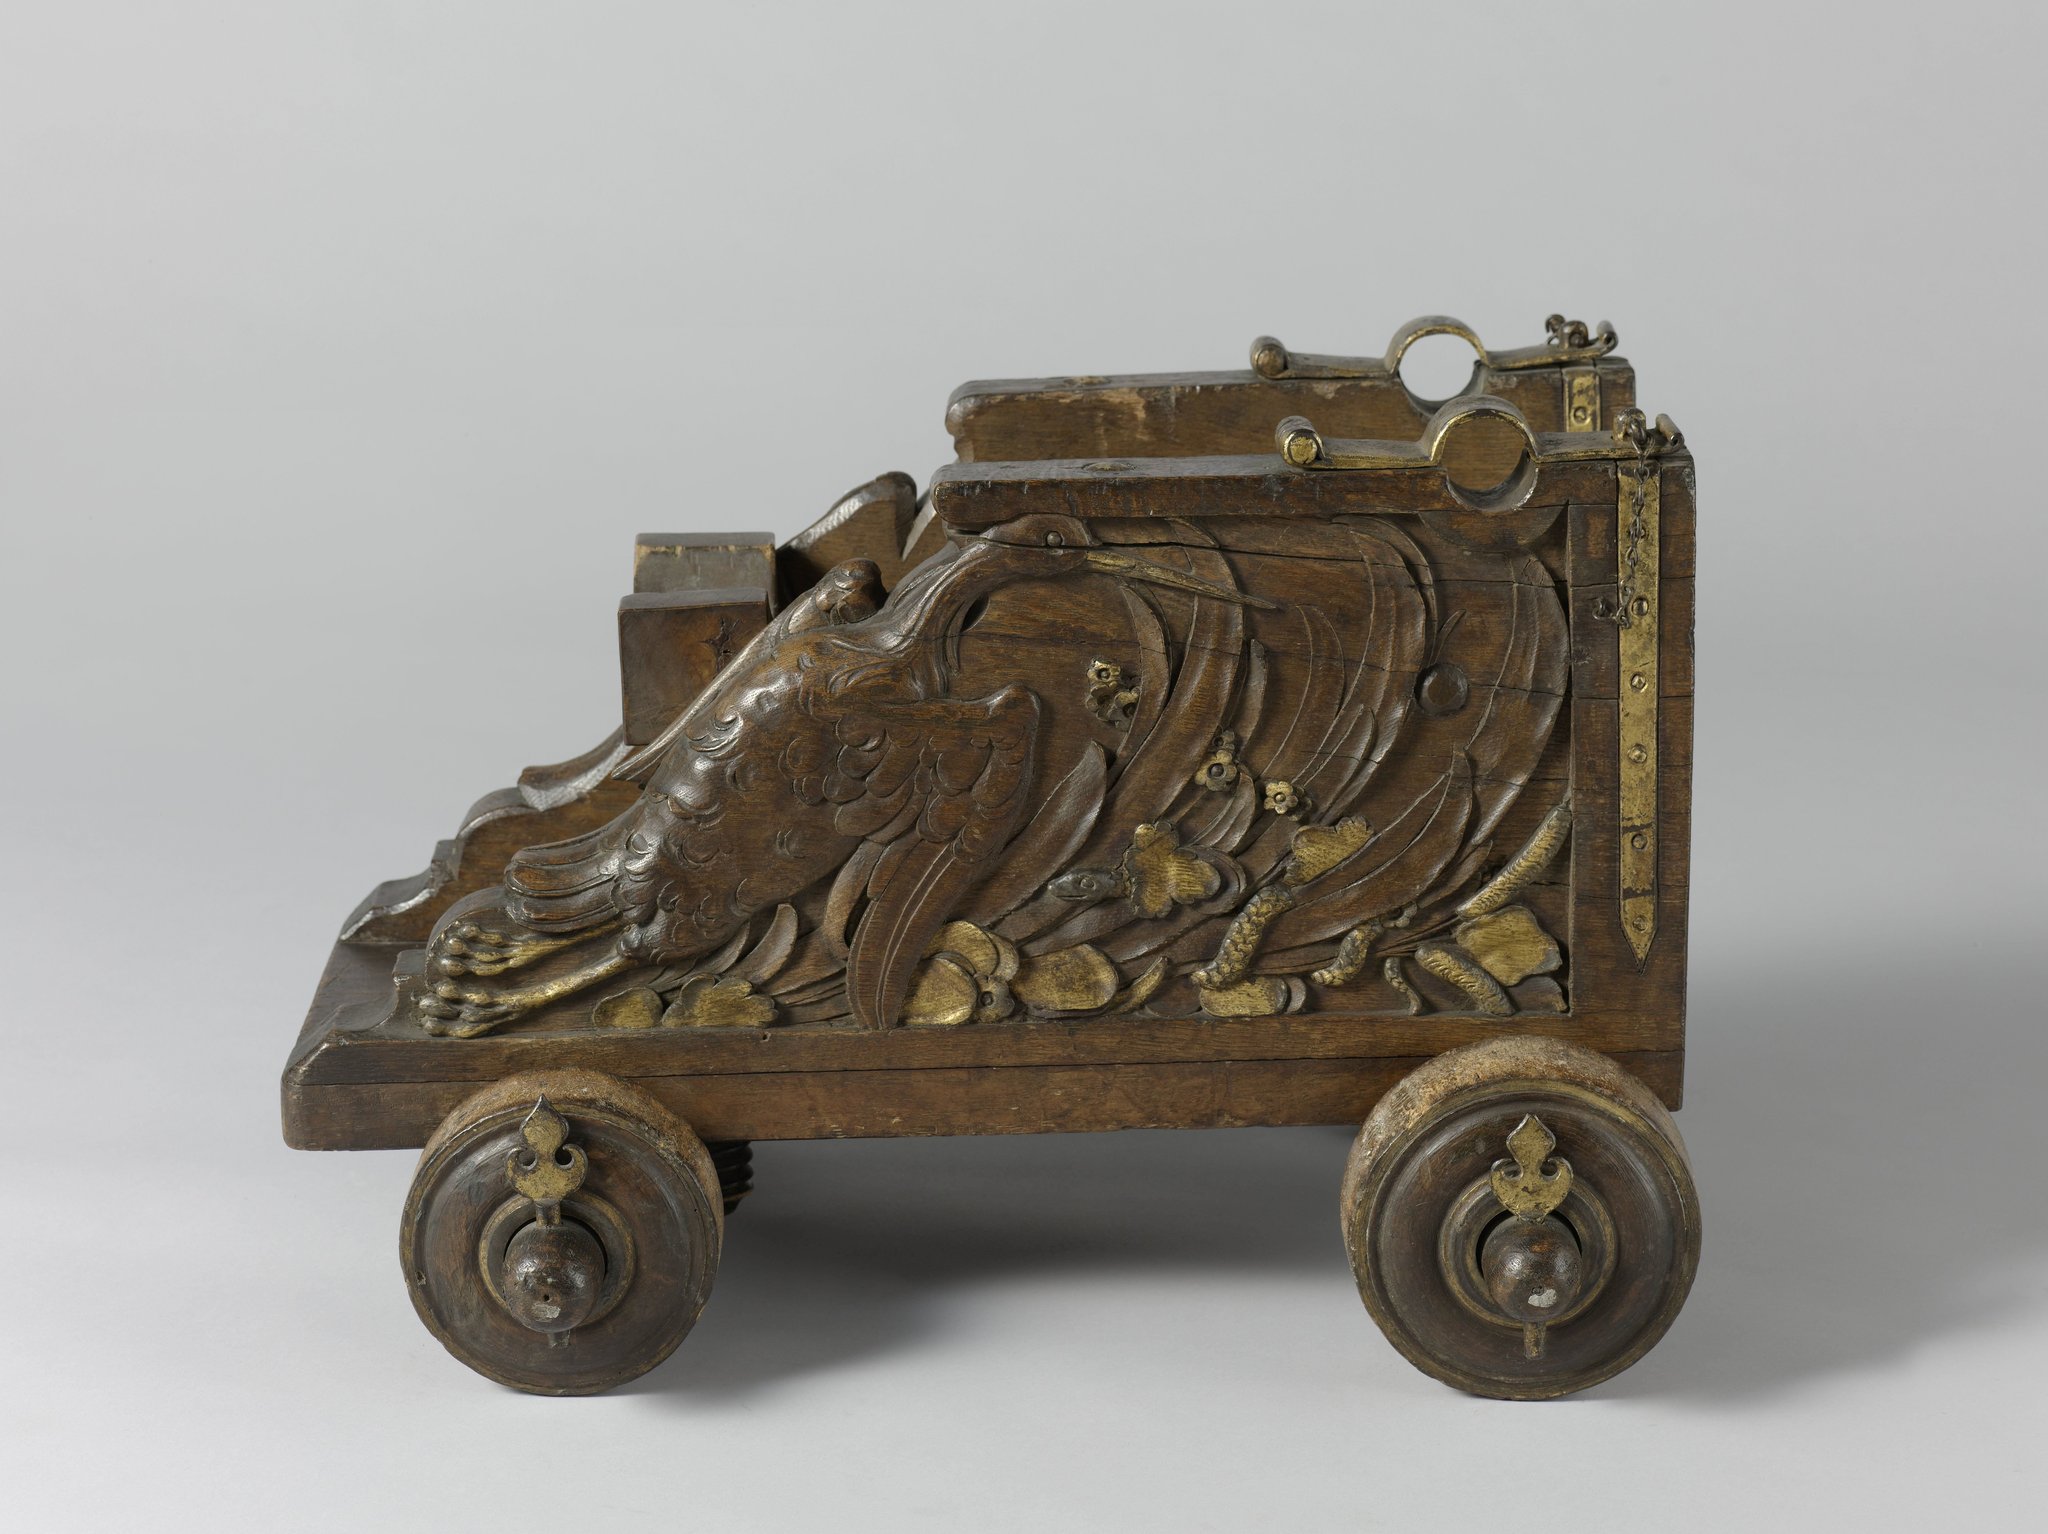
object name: wheel carriage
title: Rolpaard van het kanon van familie Reygersberg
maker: Anonymous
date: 1678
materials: iron, wood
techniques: cutting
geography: low countries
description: Oorspronkelijke eikenhouten rolpaard. Het verguld ijzeren beslagwerk is gebeeldhouwd en vertoont reigers tussen waterplanten.